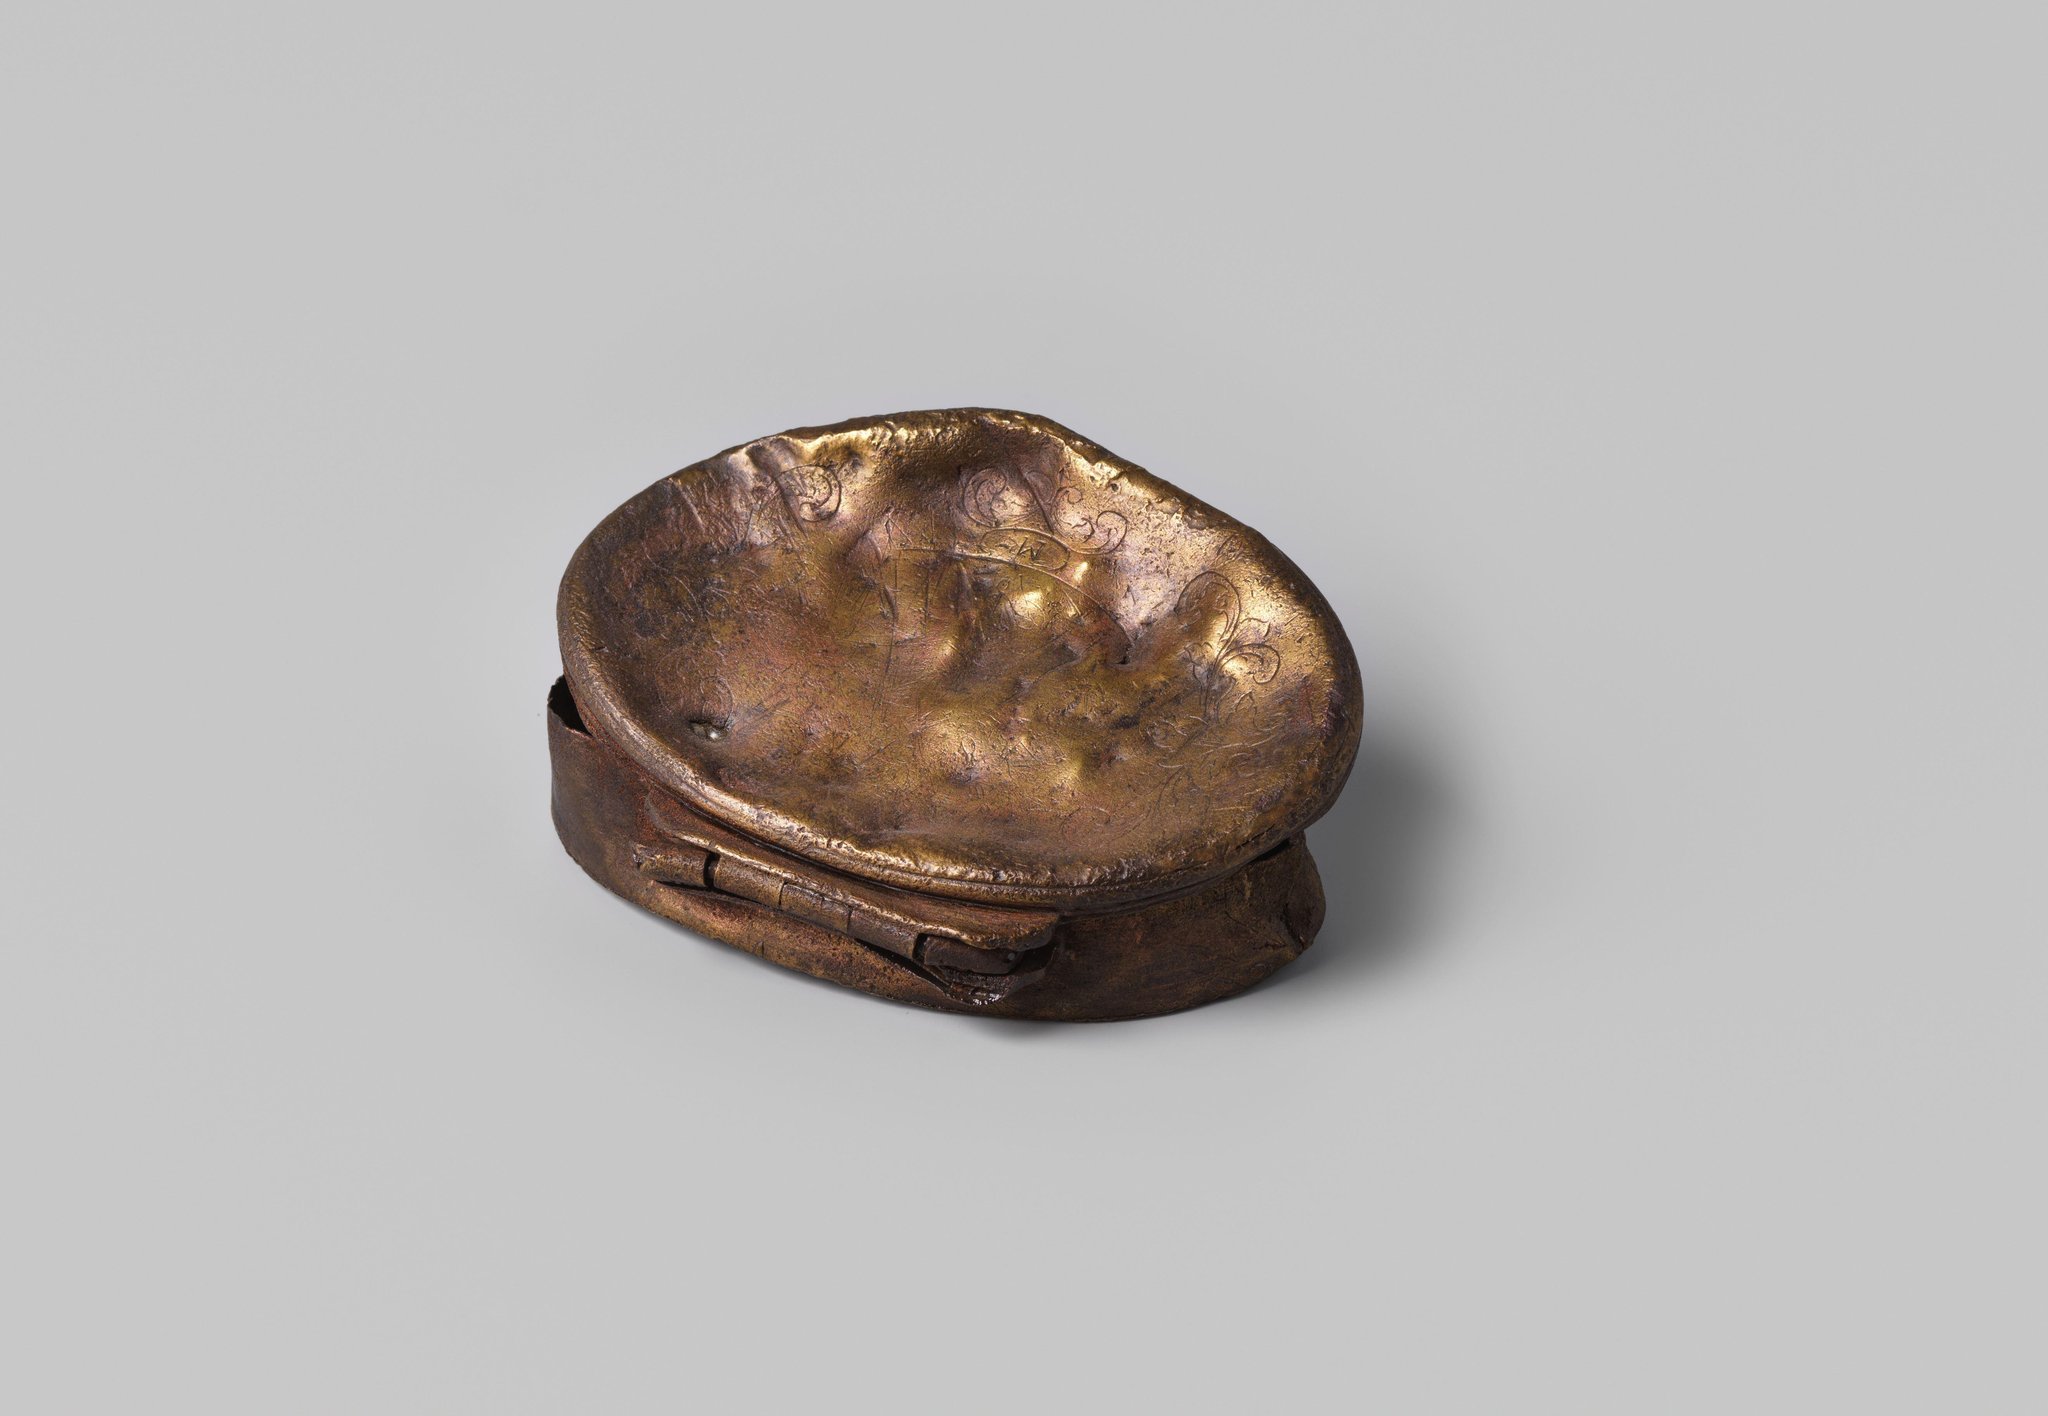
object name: snuffbox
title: Snuifdoos uit het wrak van de Oost-Indiëvaarder Hollandia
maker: Anonymous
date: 1700-1743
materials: copper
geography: netherlands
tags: verenigde oostindische compagnie, hollandia (schip), annet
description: Snuffbox; box, oval, partly damaged: five-lugged "stand-away" hinge, with lid, moulded double-reeded vertical rim, engraved decoration of foliage pattern around triangle with letter [M (?)] at base.